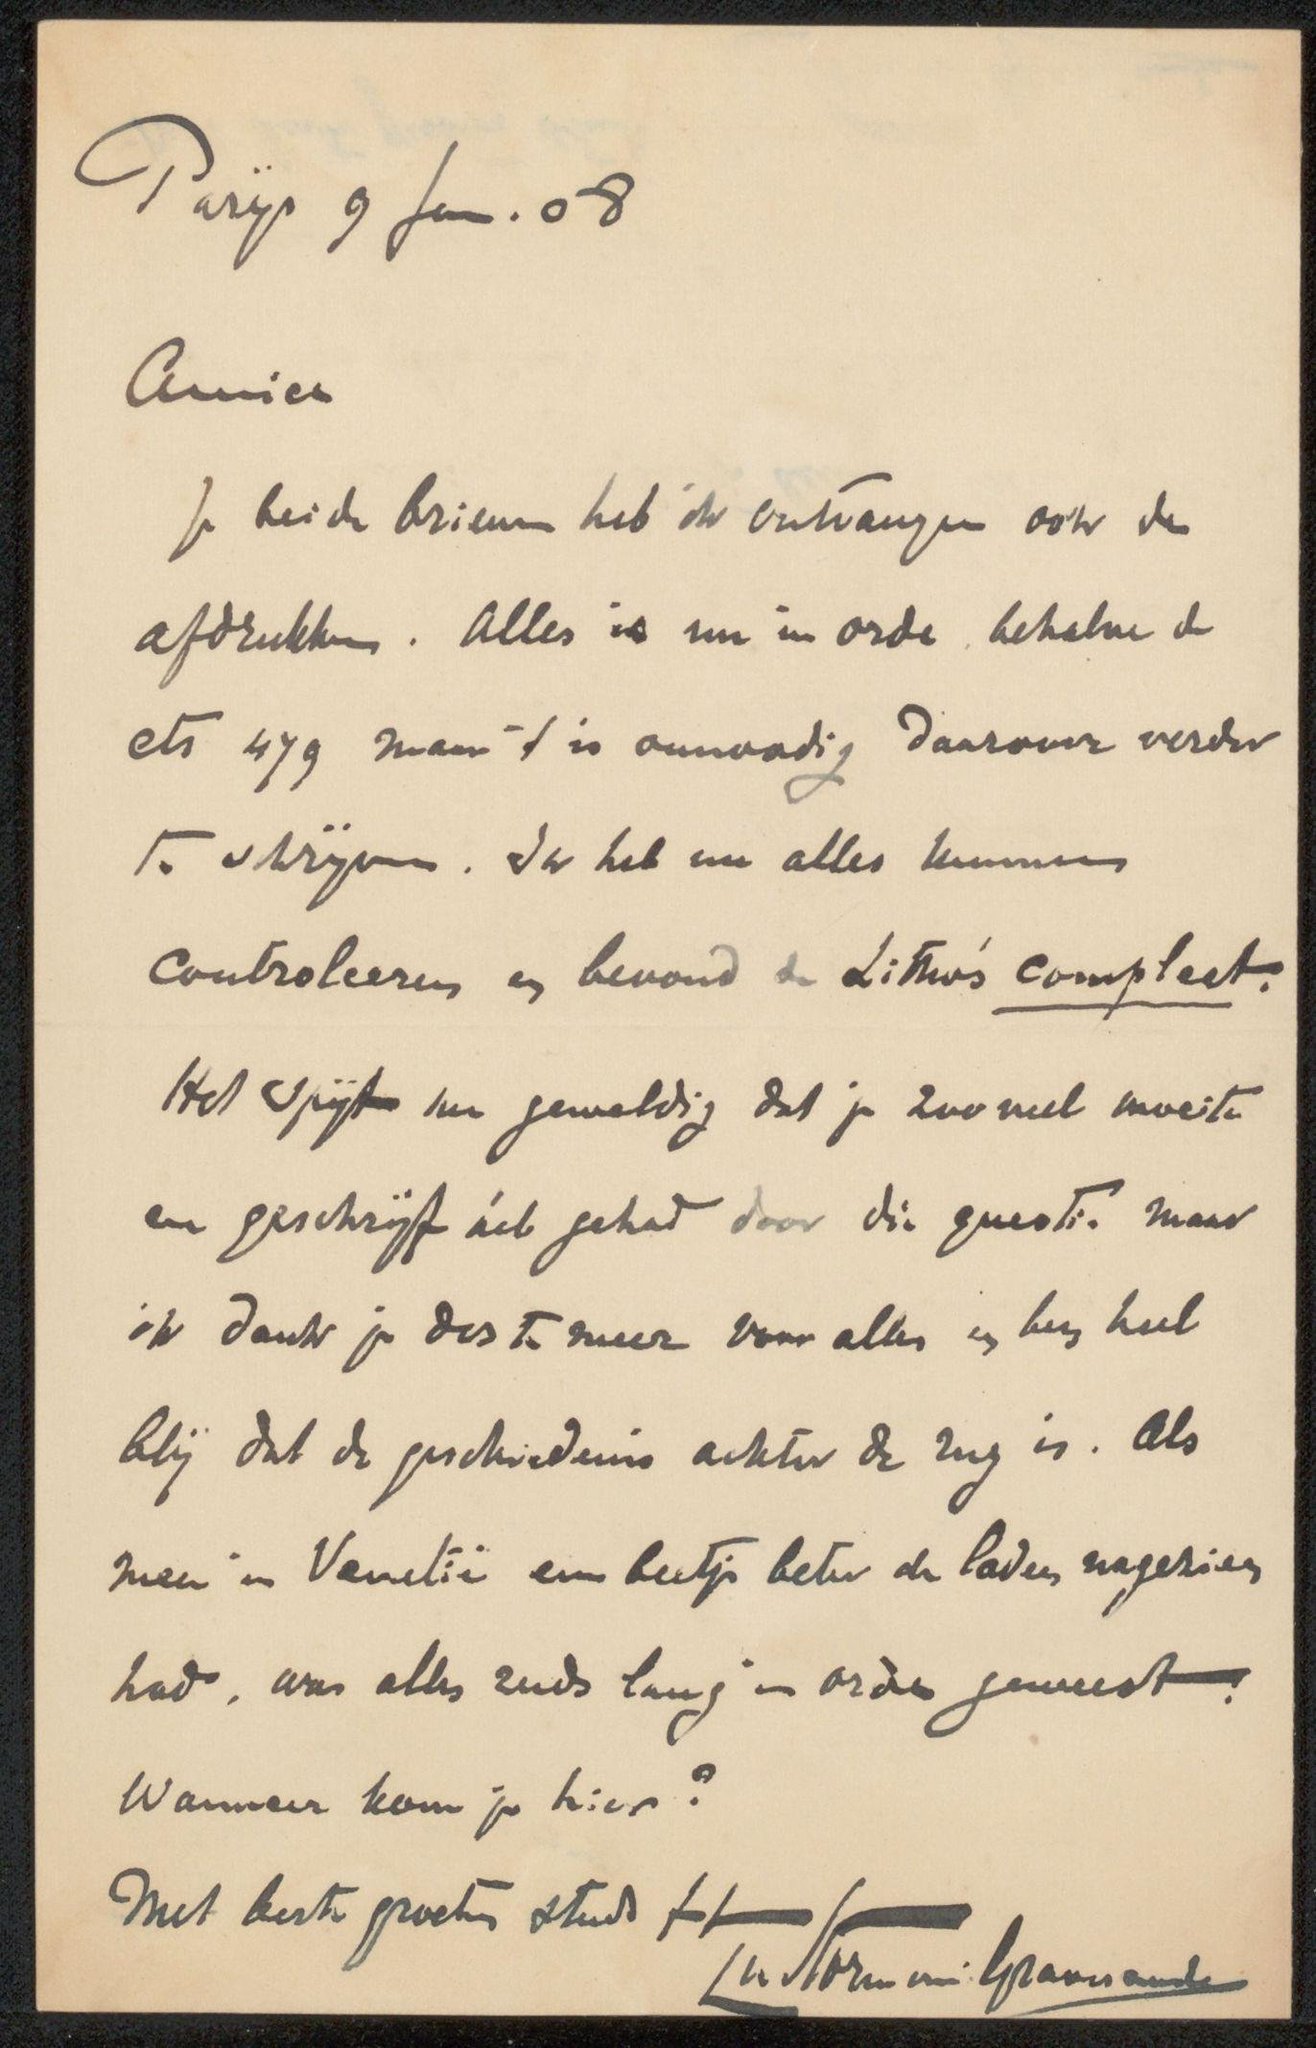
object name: letter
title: Brief aan Philip Zilcken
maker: carel nicolaas storm van s-gravesande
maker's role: draughtsman, print maker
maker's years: 1841-1924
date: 1908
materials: ink, paper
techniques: pen, writing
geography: paris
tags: painter, philip zilcken, the graphic arts, venice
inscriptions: collector's mark: ‘RPK’, watermark